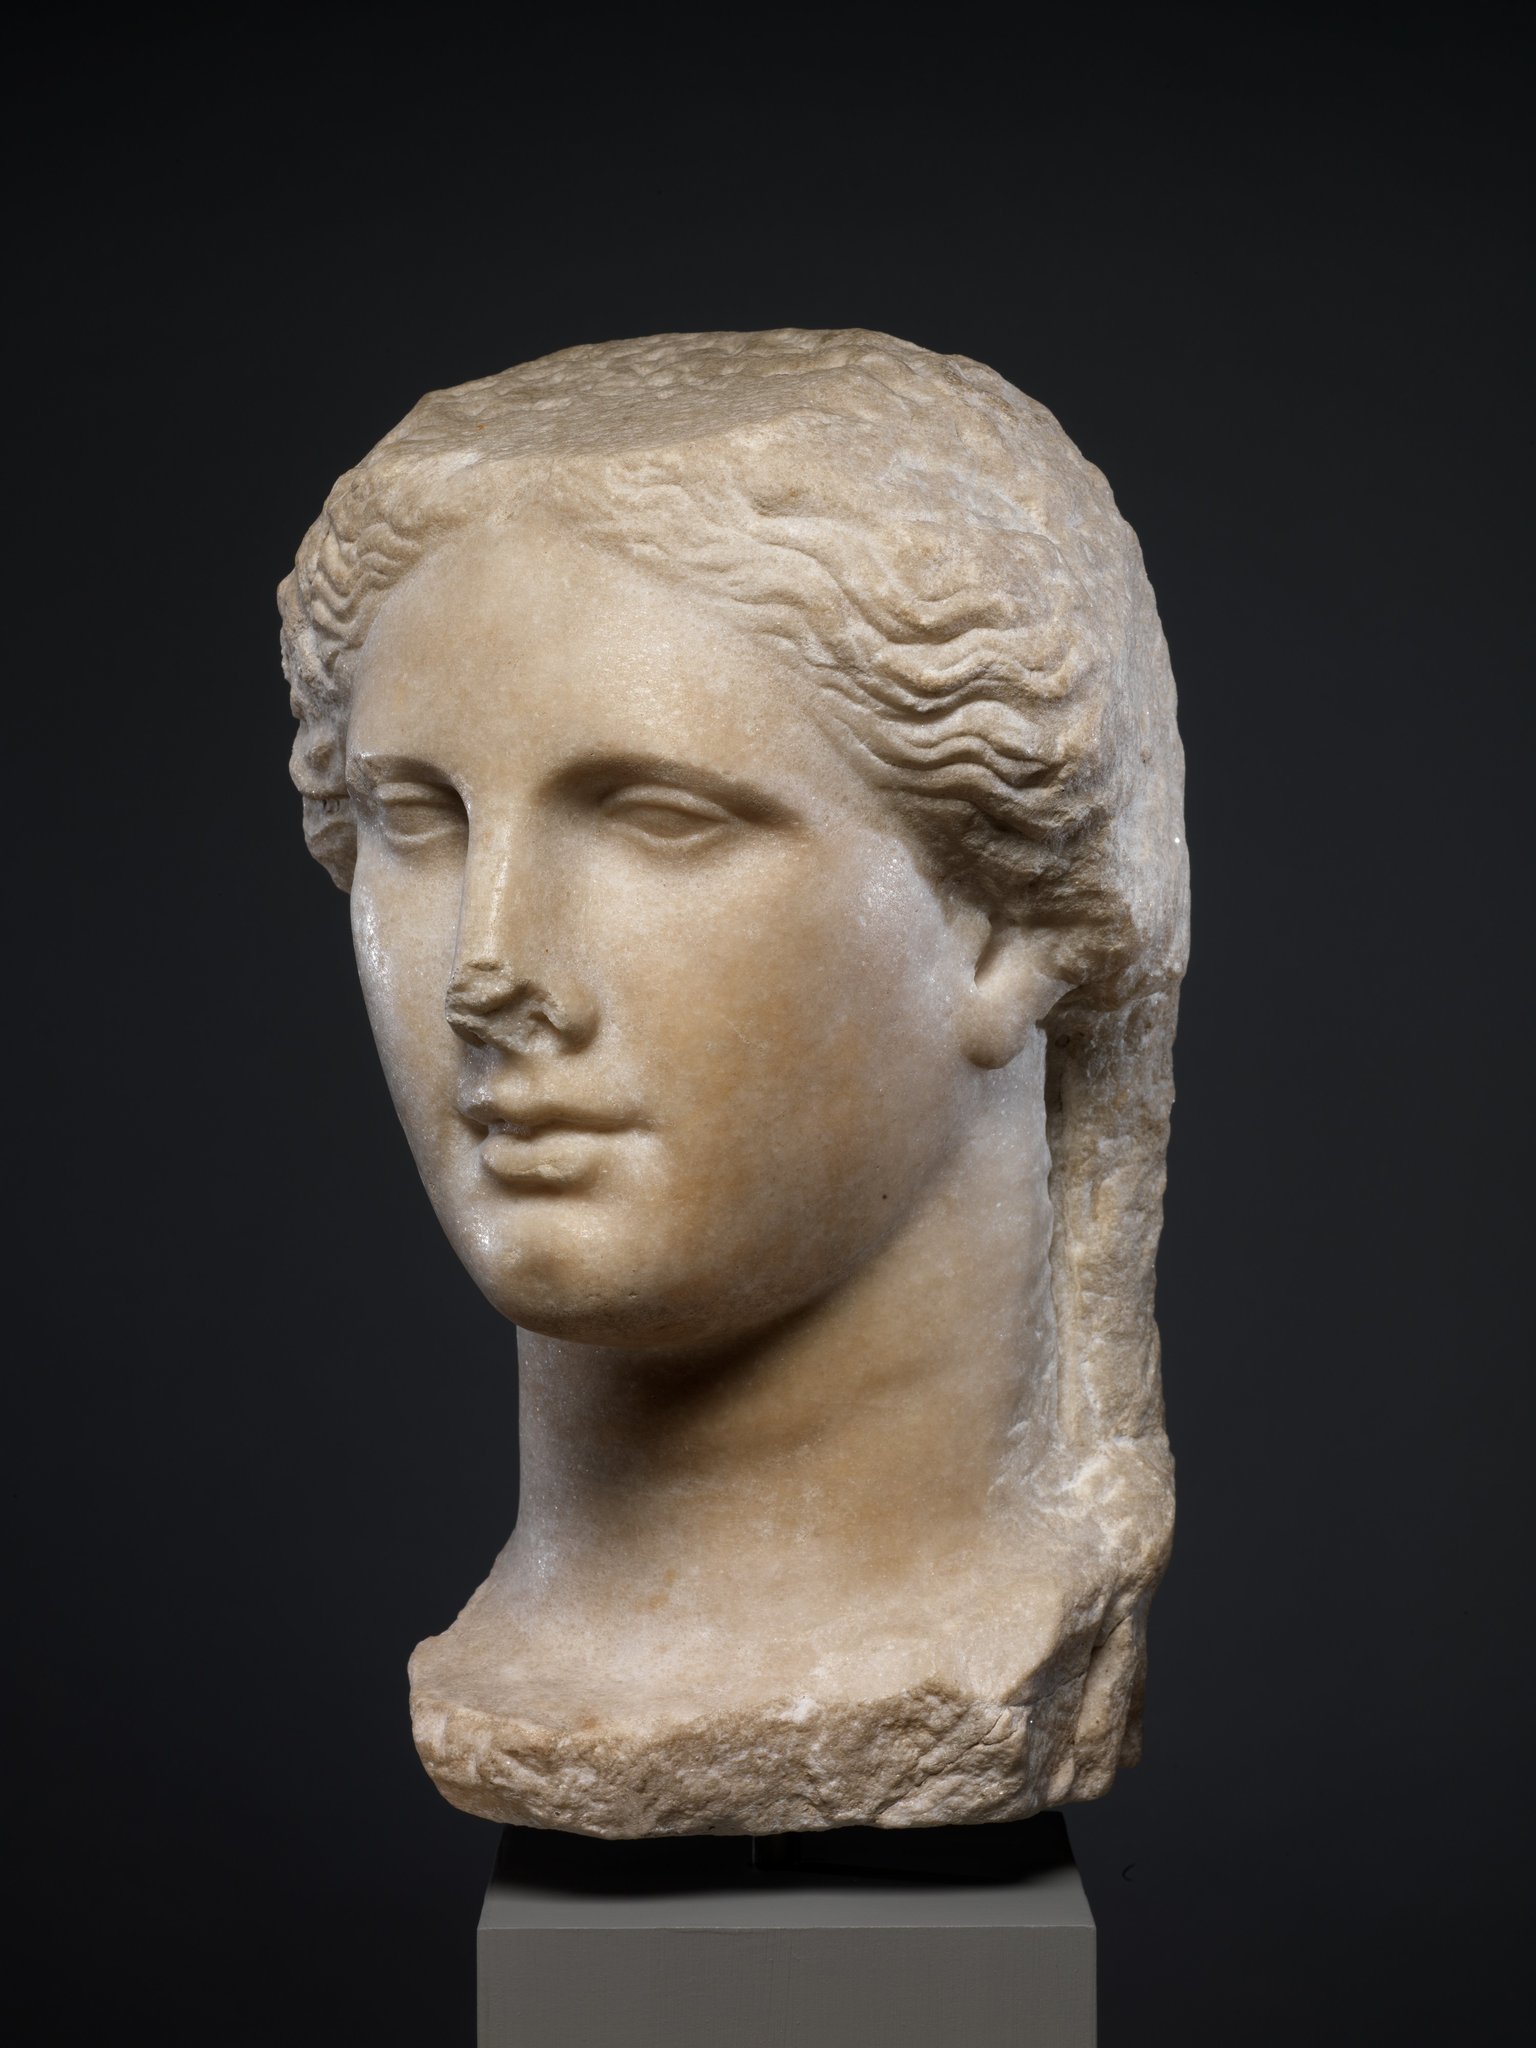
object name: head of a ptolemaic queen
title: Marble head of a Ptolemaic queen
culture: greek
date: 270-250 BCE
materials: marble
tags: queens,heads,women